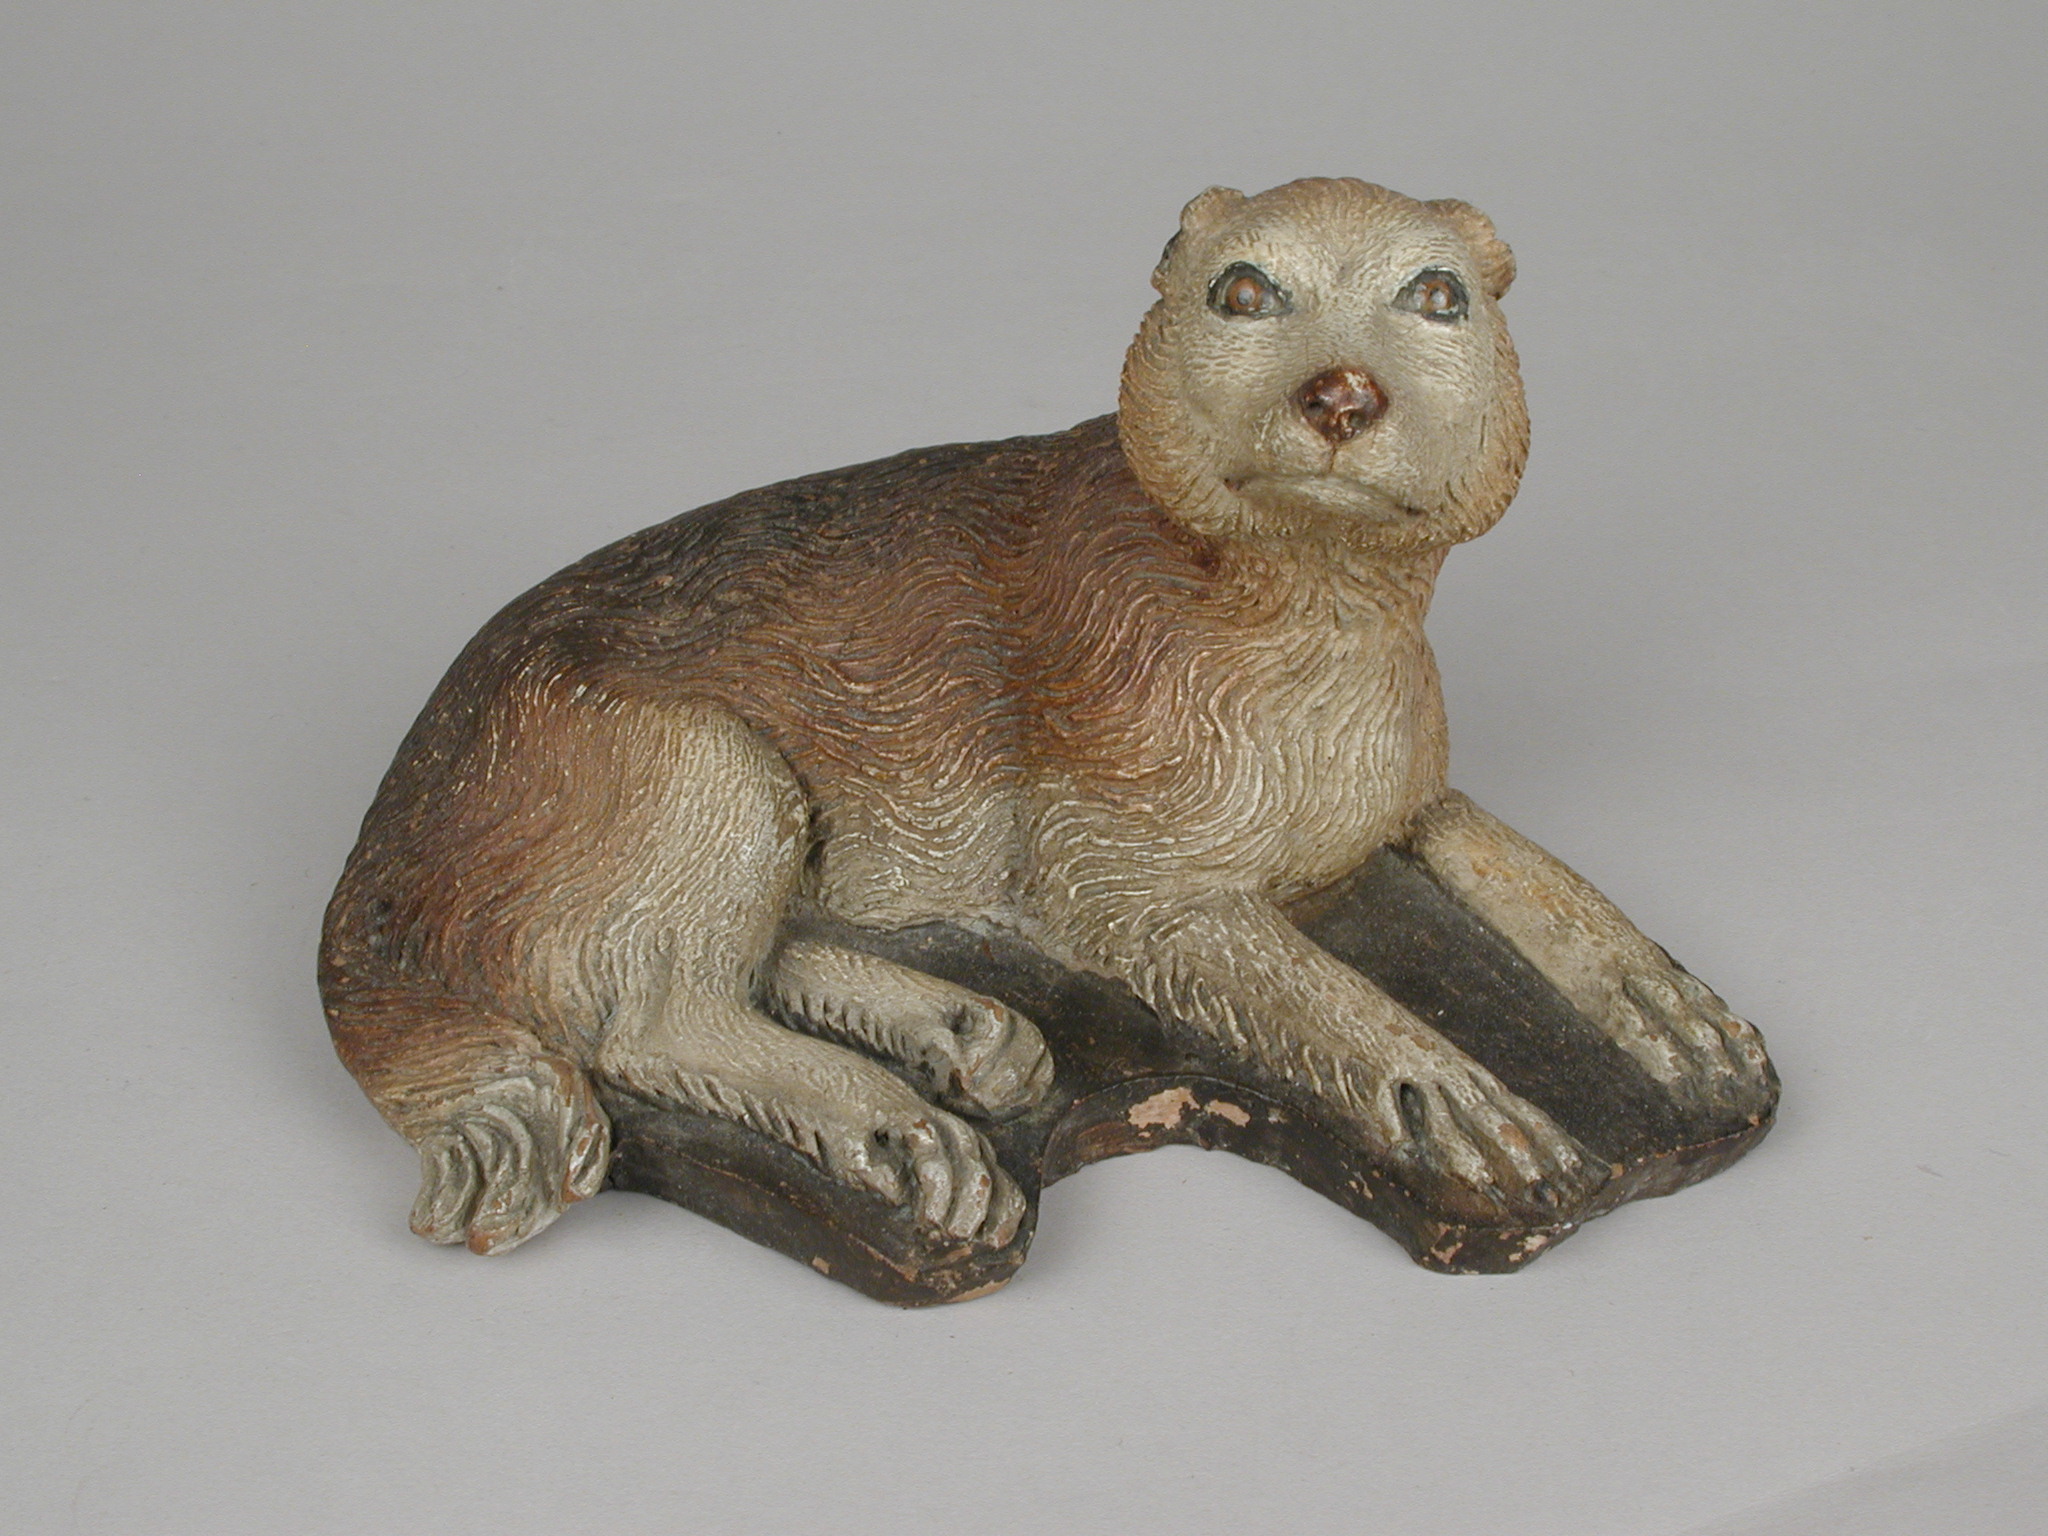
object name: crèche figure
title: Reclining sheepdog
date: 1701-1900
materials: terracotta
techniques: polychrome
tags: dogs